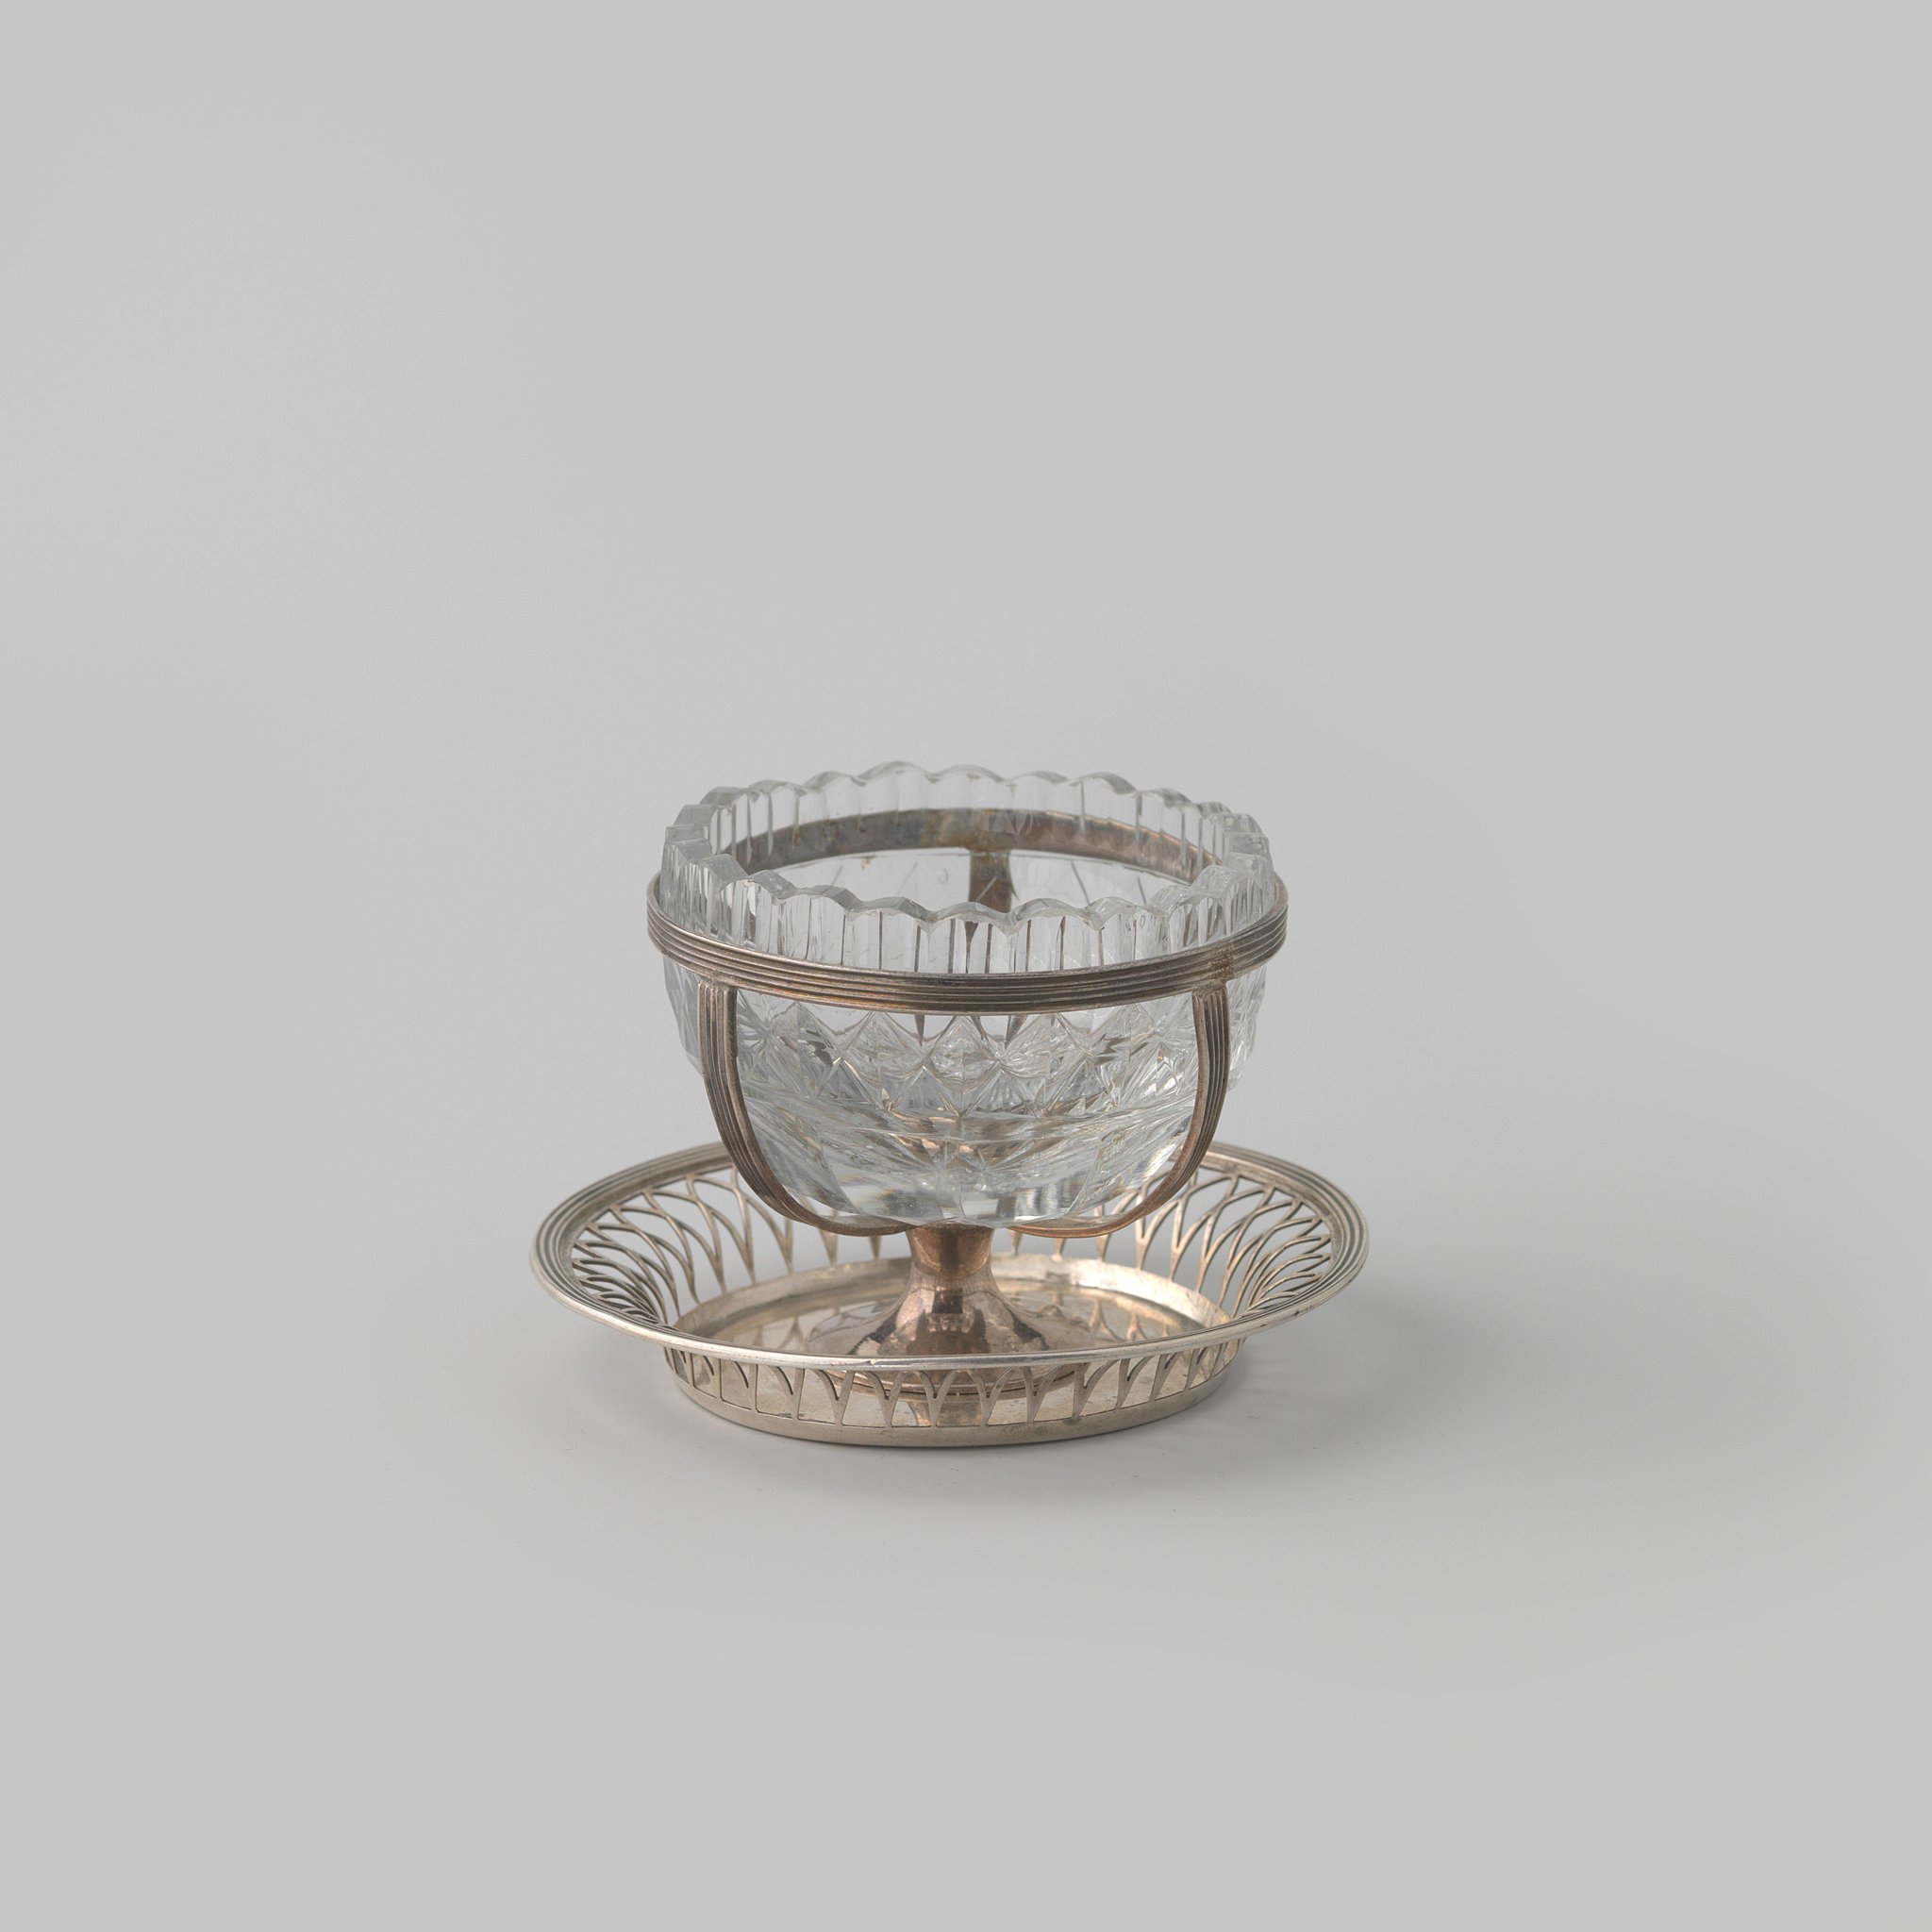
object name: salt condiment vessel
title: Zoutvat, rond, met glazen bak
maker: hendrik smits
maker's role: silversmith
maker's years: 1772-1841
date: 1807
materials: glass, silver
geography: amsterdam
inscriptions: date letter: ‘Y’, retailer's mark: ‘DIEMONT’, duty mark, maker's mark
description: Het ronde zoutvat heeft een losse binnenbak. De half bolvormige, open houder is opgebouwd uit een bovenring waar drie gebogen stangen aan zijn bevestigd. Deze zijn alle versierd met filetranden. Aan de onderzijde komen de stangen samen op een gewelfde voet. Deze is vastgeschroefd op een schaaltje met een gewelfde, met tranen opengewerkte wand, die aan de bovenzijde wordt afgesloten door een filetrand. De binnenbak van kleurloos glas heeft een gegolfde bovenrand en is geslepen met een knerrenrand, waaronder een rand van diamantkoppen boven een stralenkrans.